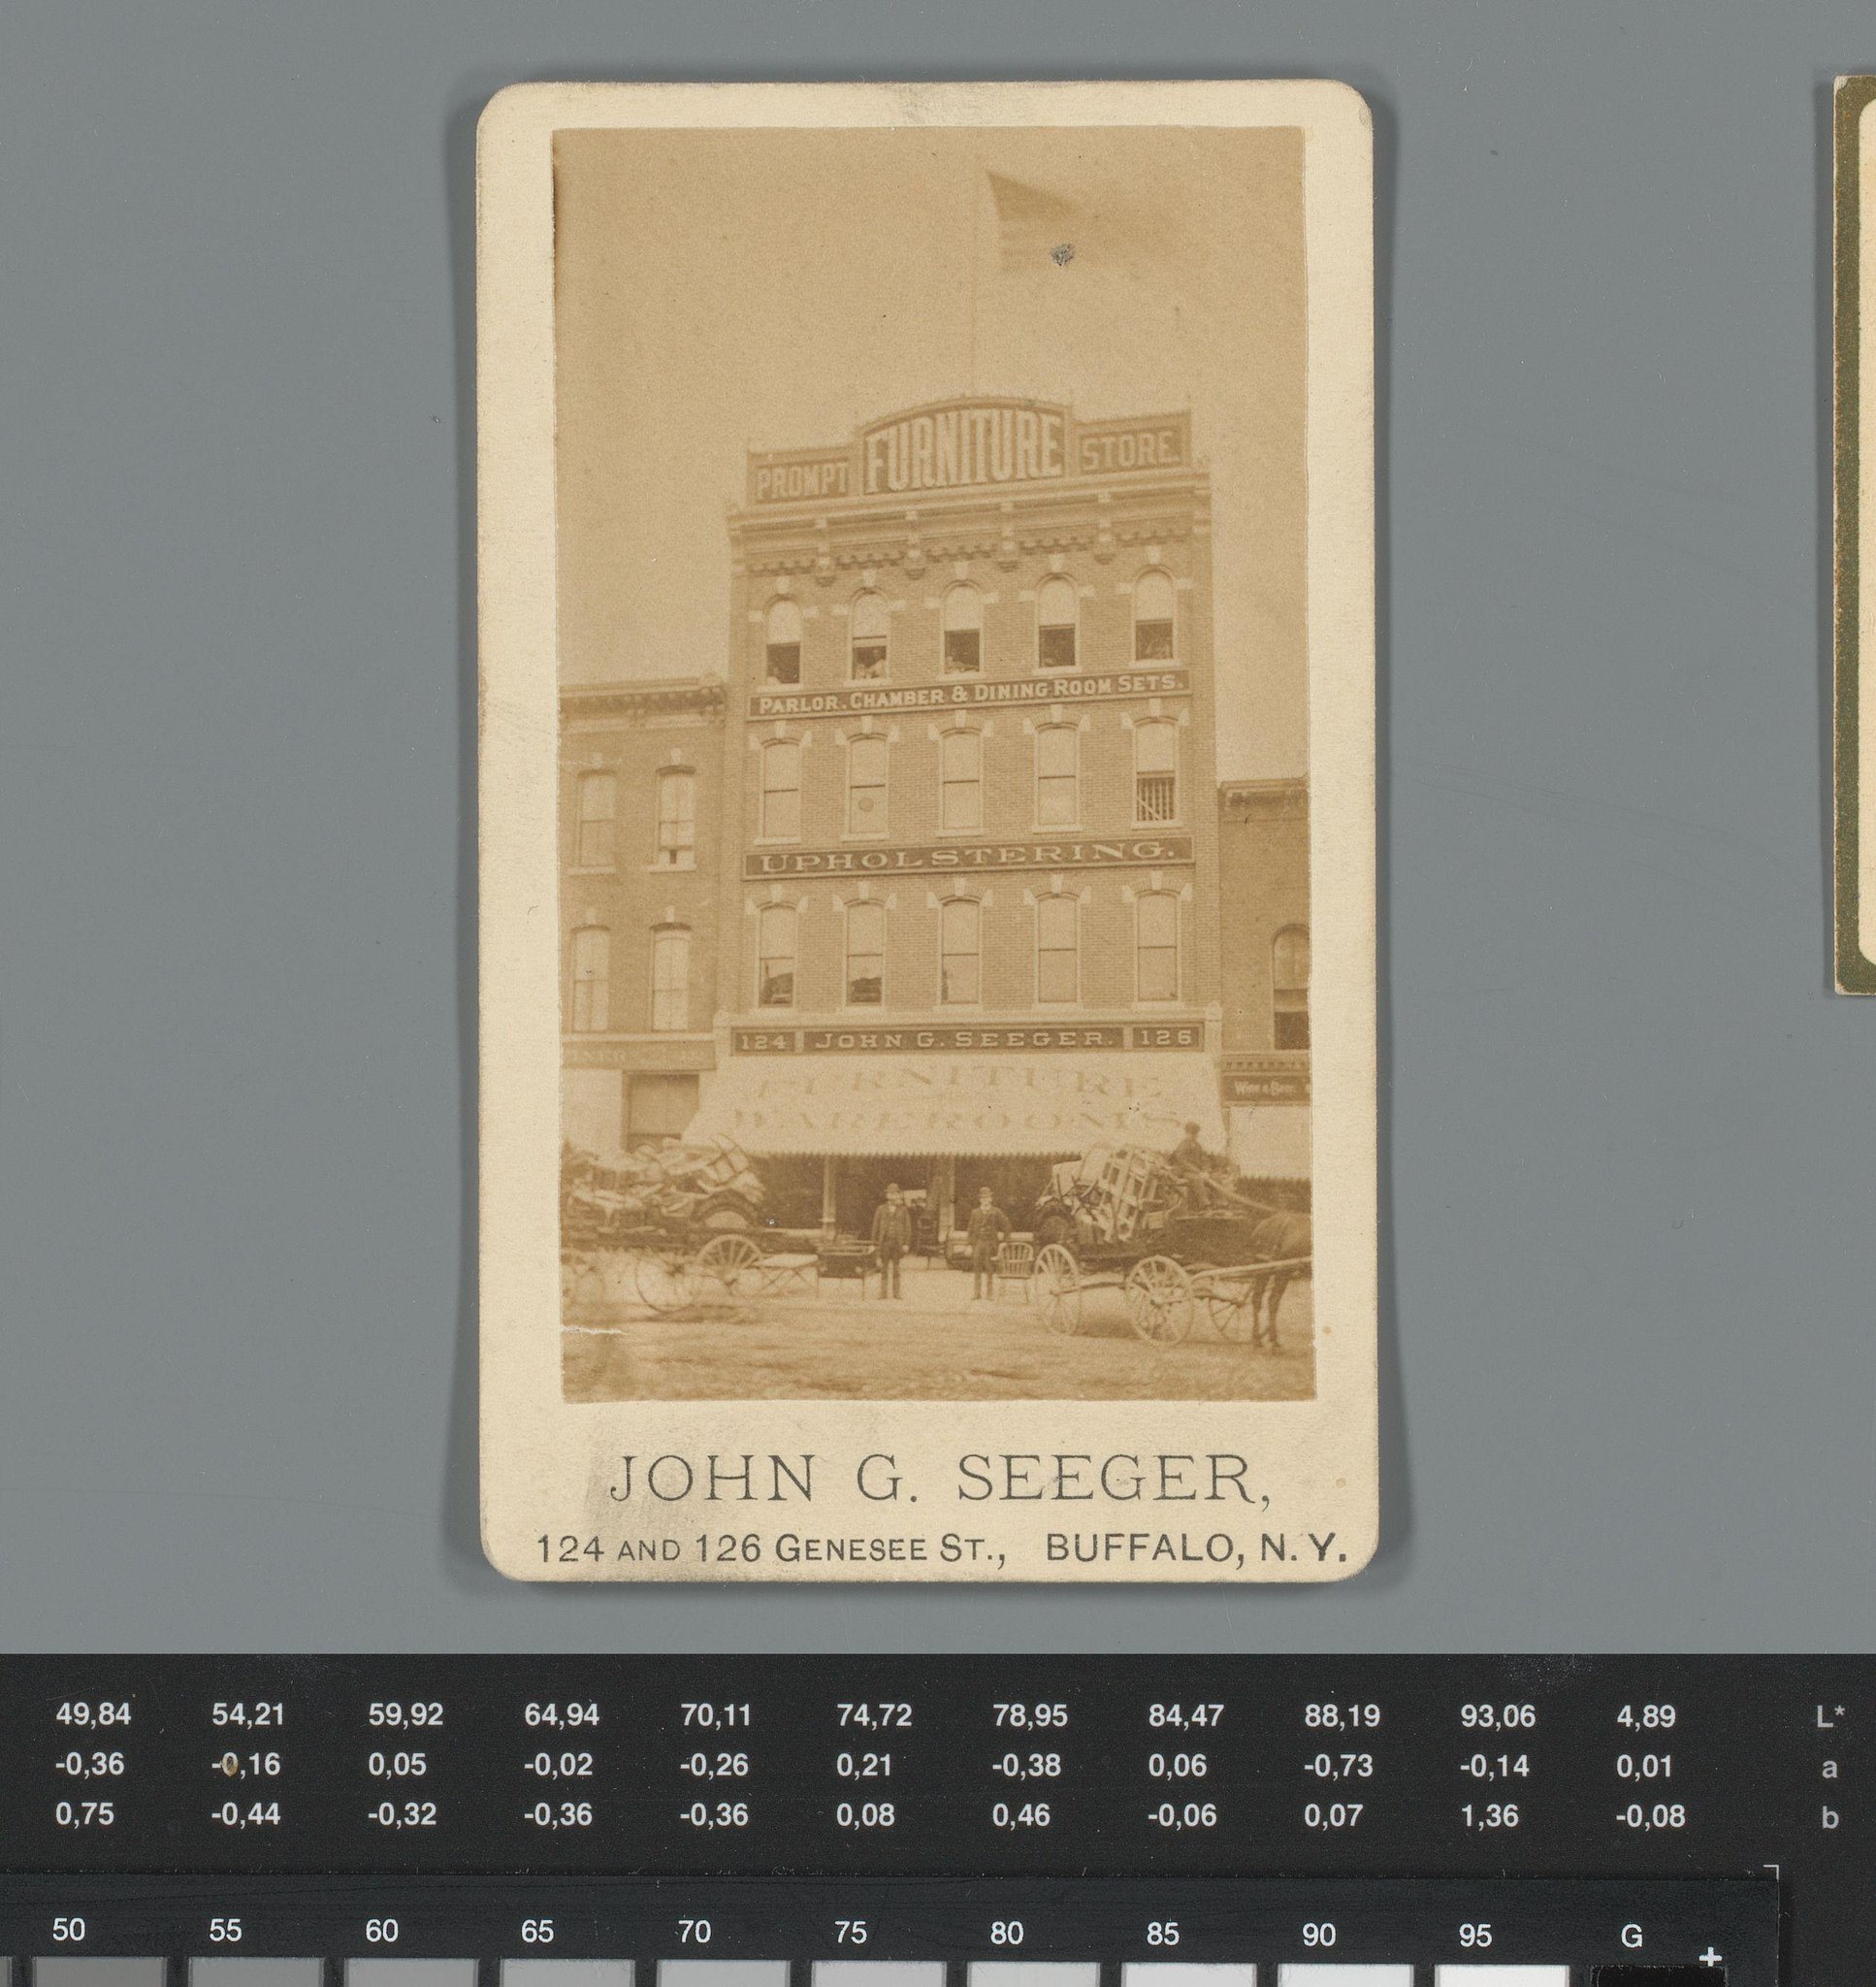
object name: photograph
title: Reclame voor meubels van John G. Seeger met gezicht op zijn winkel in Buffalo, New York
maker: Anonymous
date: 1850-1915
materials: cardboard, photographic support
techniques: albumen print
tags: shop, store, advertising